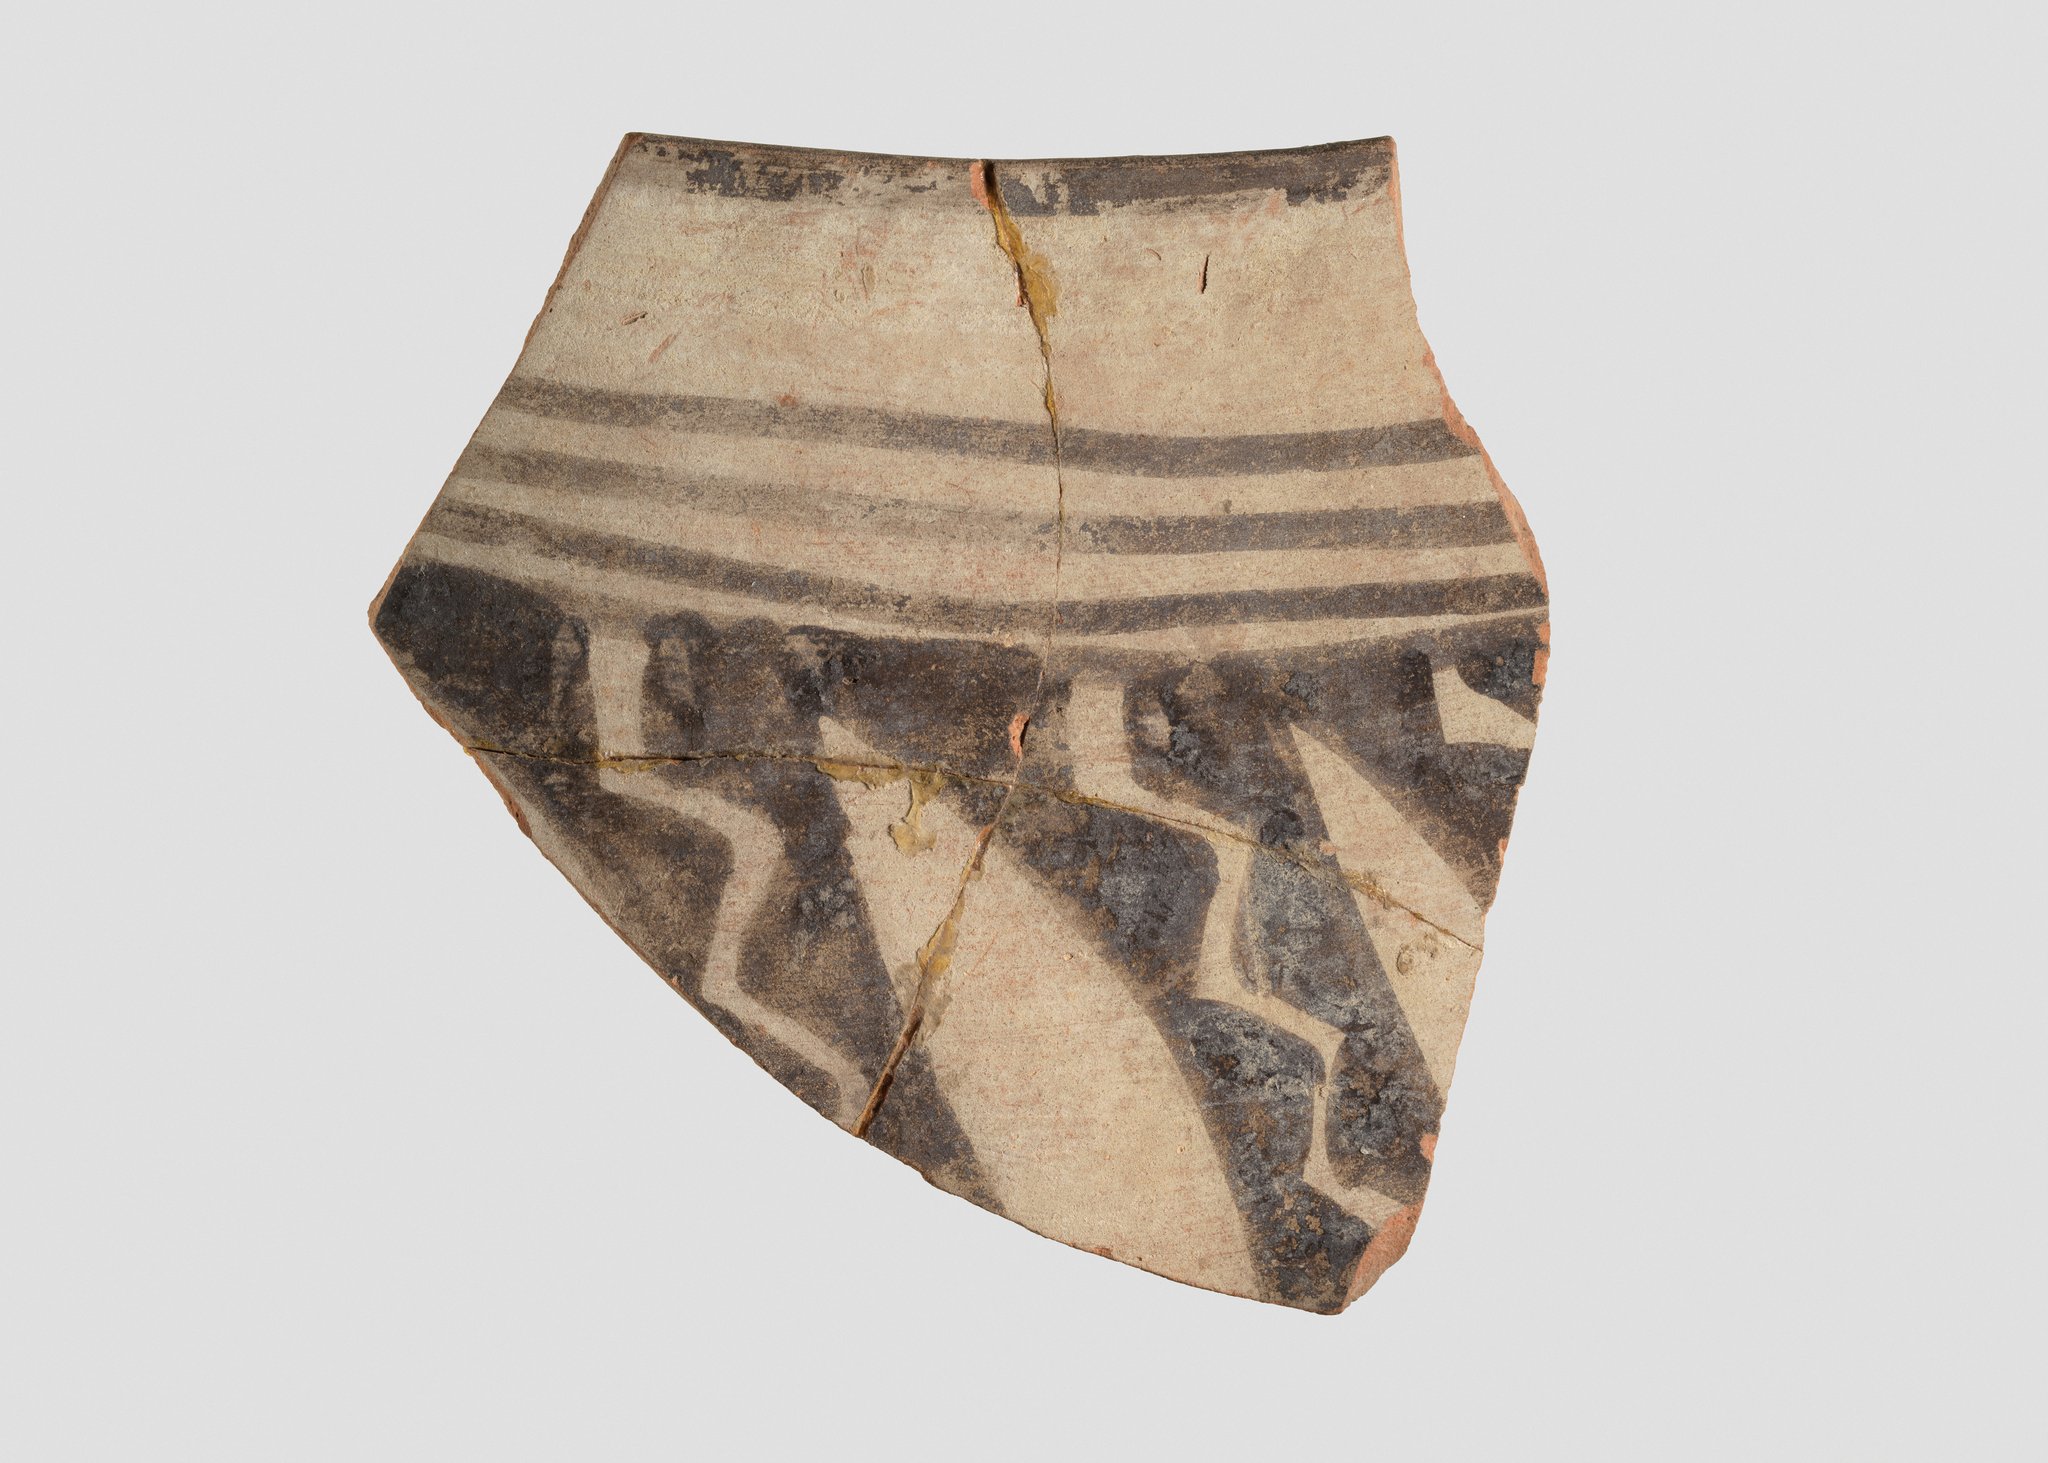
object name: sherd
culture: indus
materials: ceramic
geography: indus region